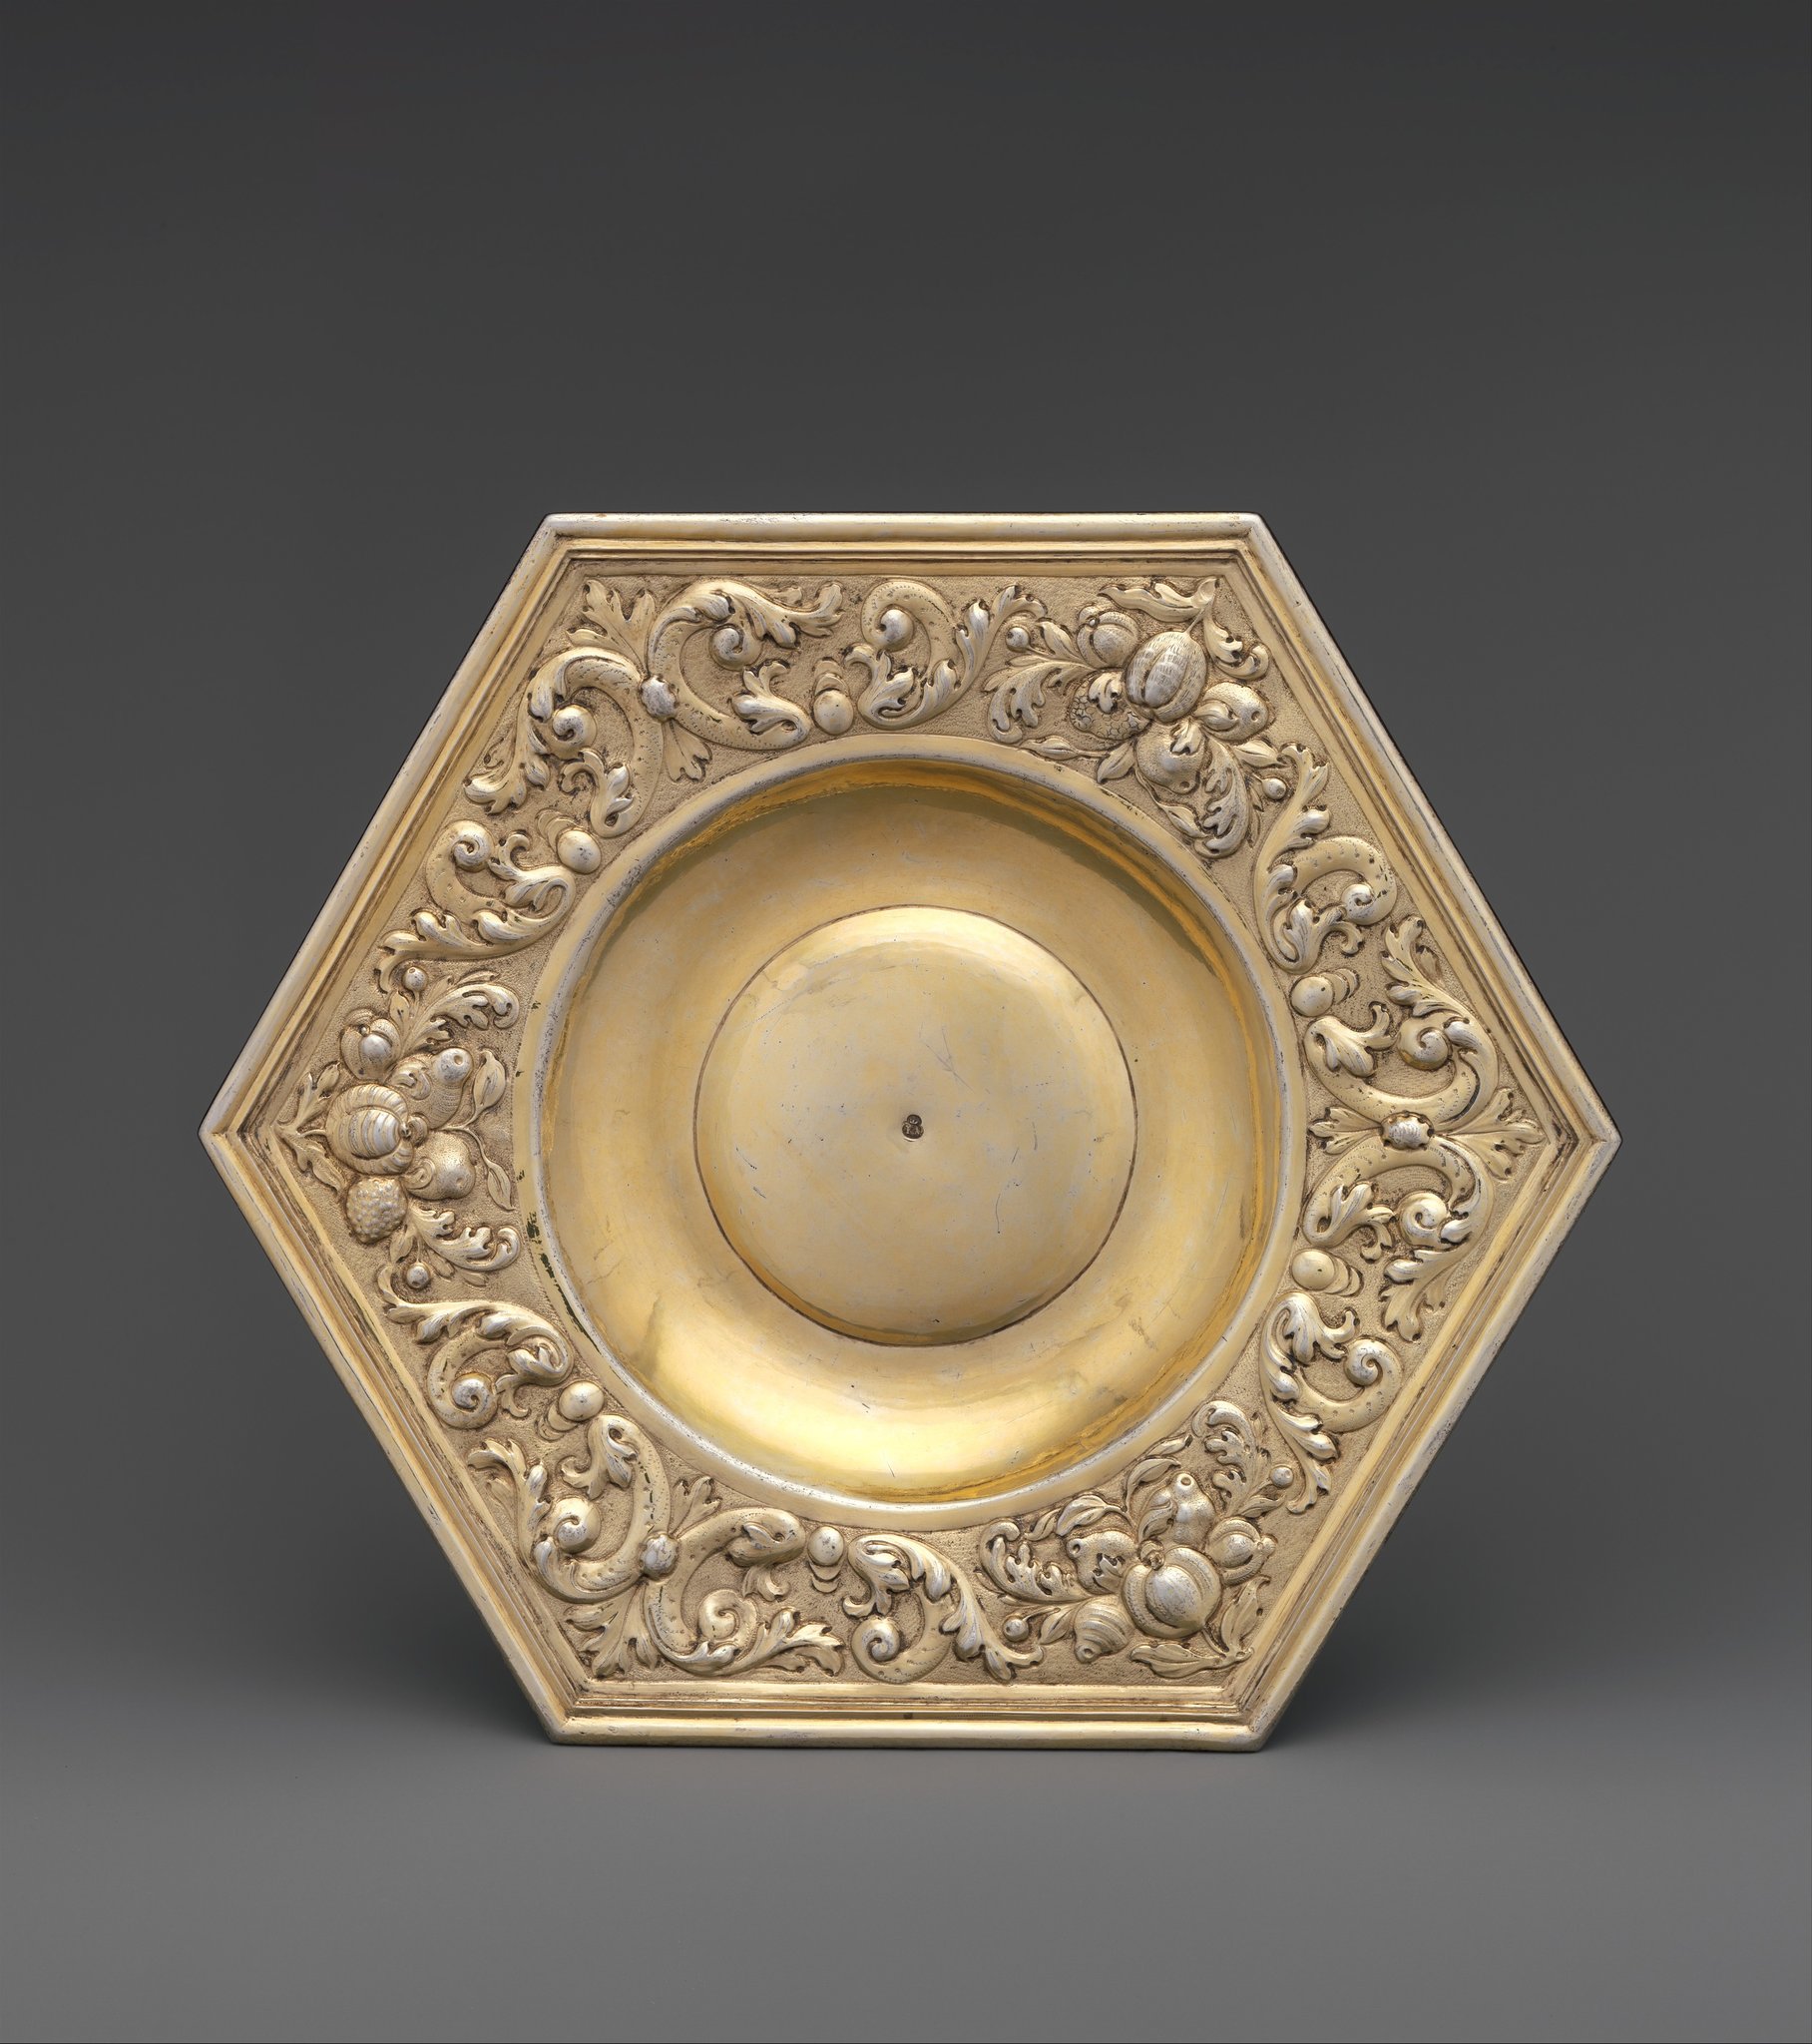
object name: dish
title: Hexagonal dish (part of a set)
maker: paulus roth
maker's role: maker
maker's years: 1589-1689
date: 1651-1700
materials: gilt silver